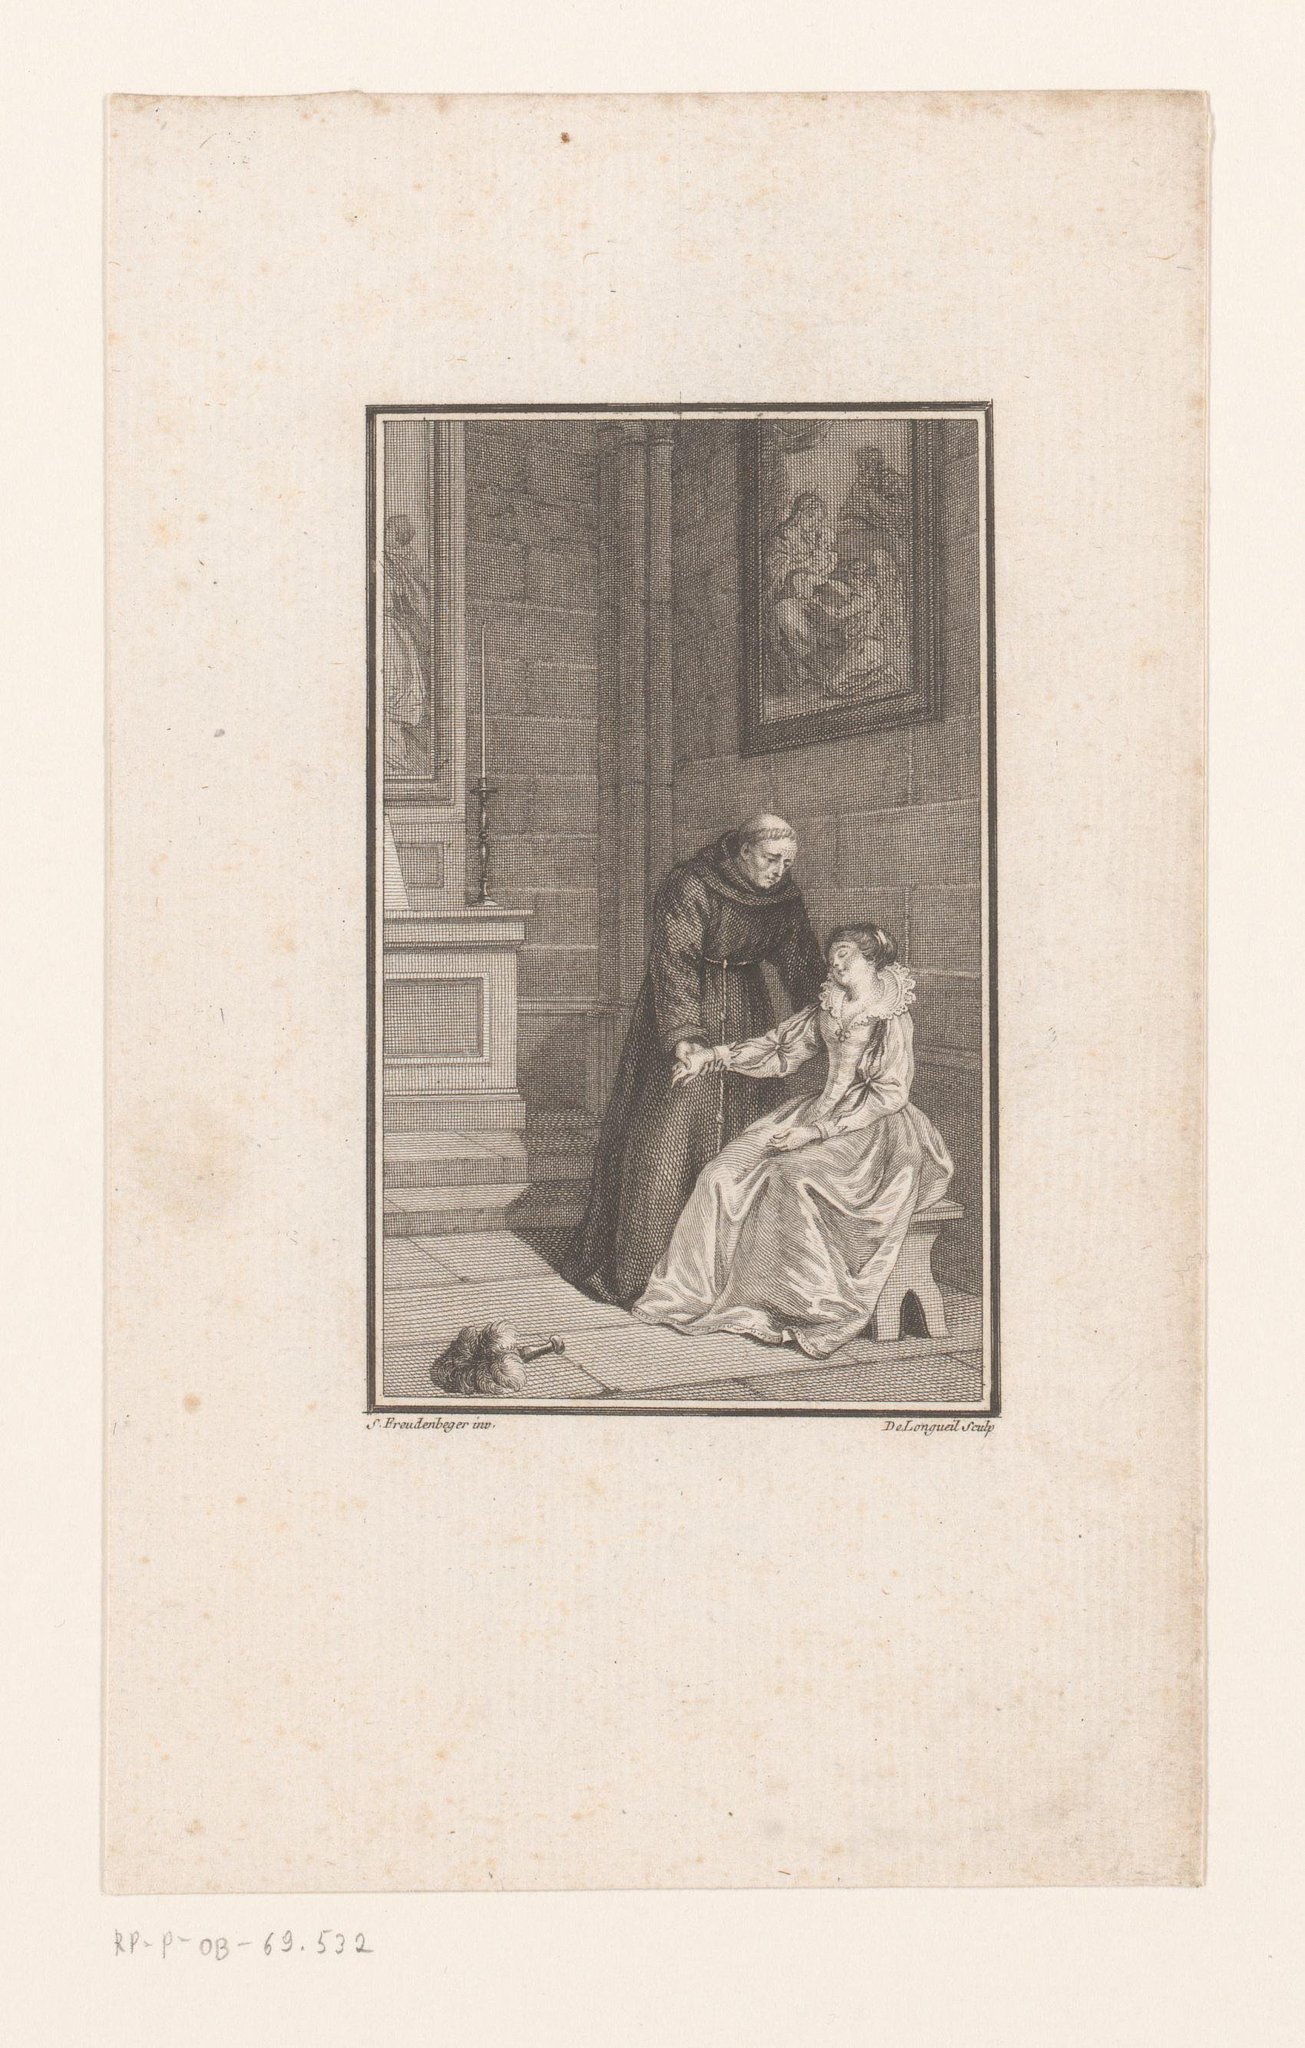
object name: book illustration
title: D'un gentilhomme qui, n'ayant pu épouser une jeune fille qu'il aimait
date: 1780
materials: paper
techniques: engraving, etching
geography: france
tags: sitting figure - aa - female human figure, monk(s), friar(s)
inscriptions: collector's mark: Lugt 2228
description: Prent uit: Margaretha van Frankrijk. Les nouvelles de Marguerite, reine de Navarre. Bern: La Nouvelle Société Typographique, 1780.